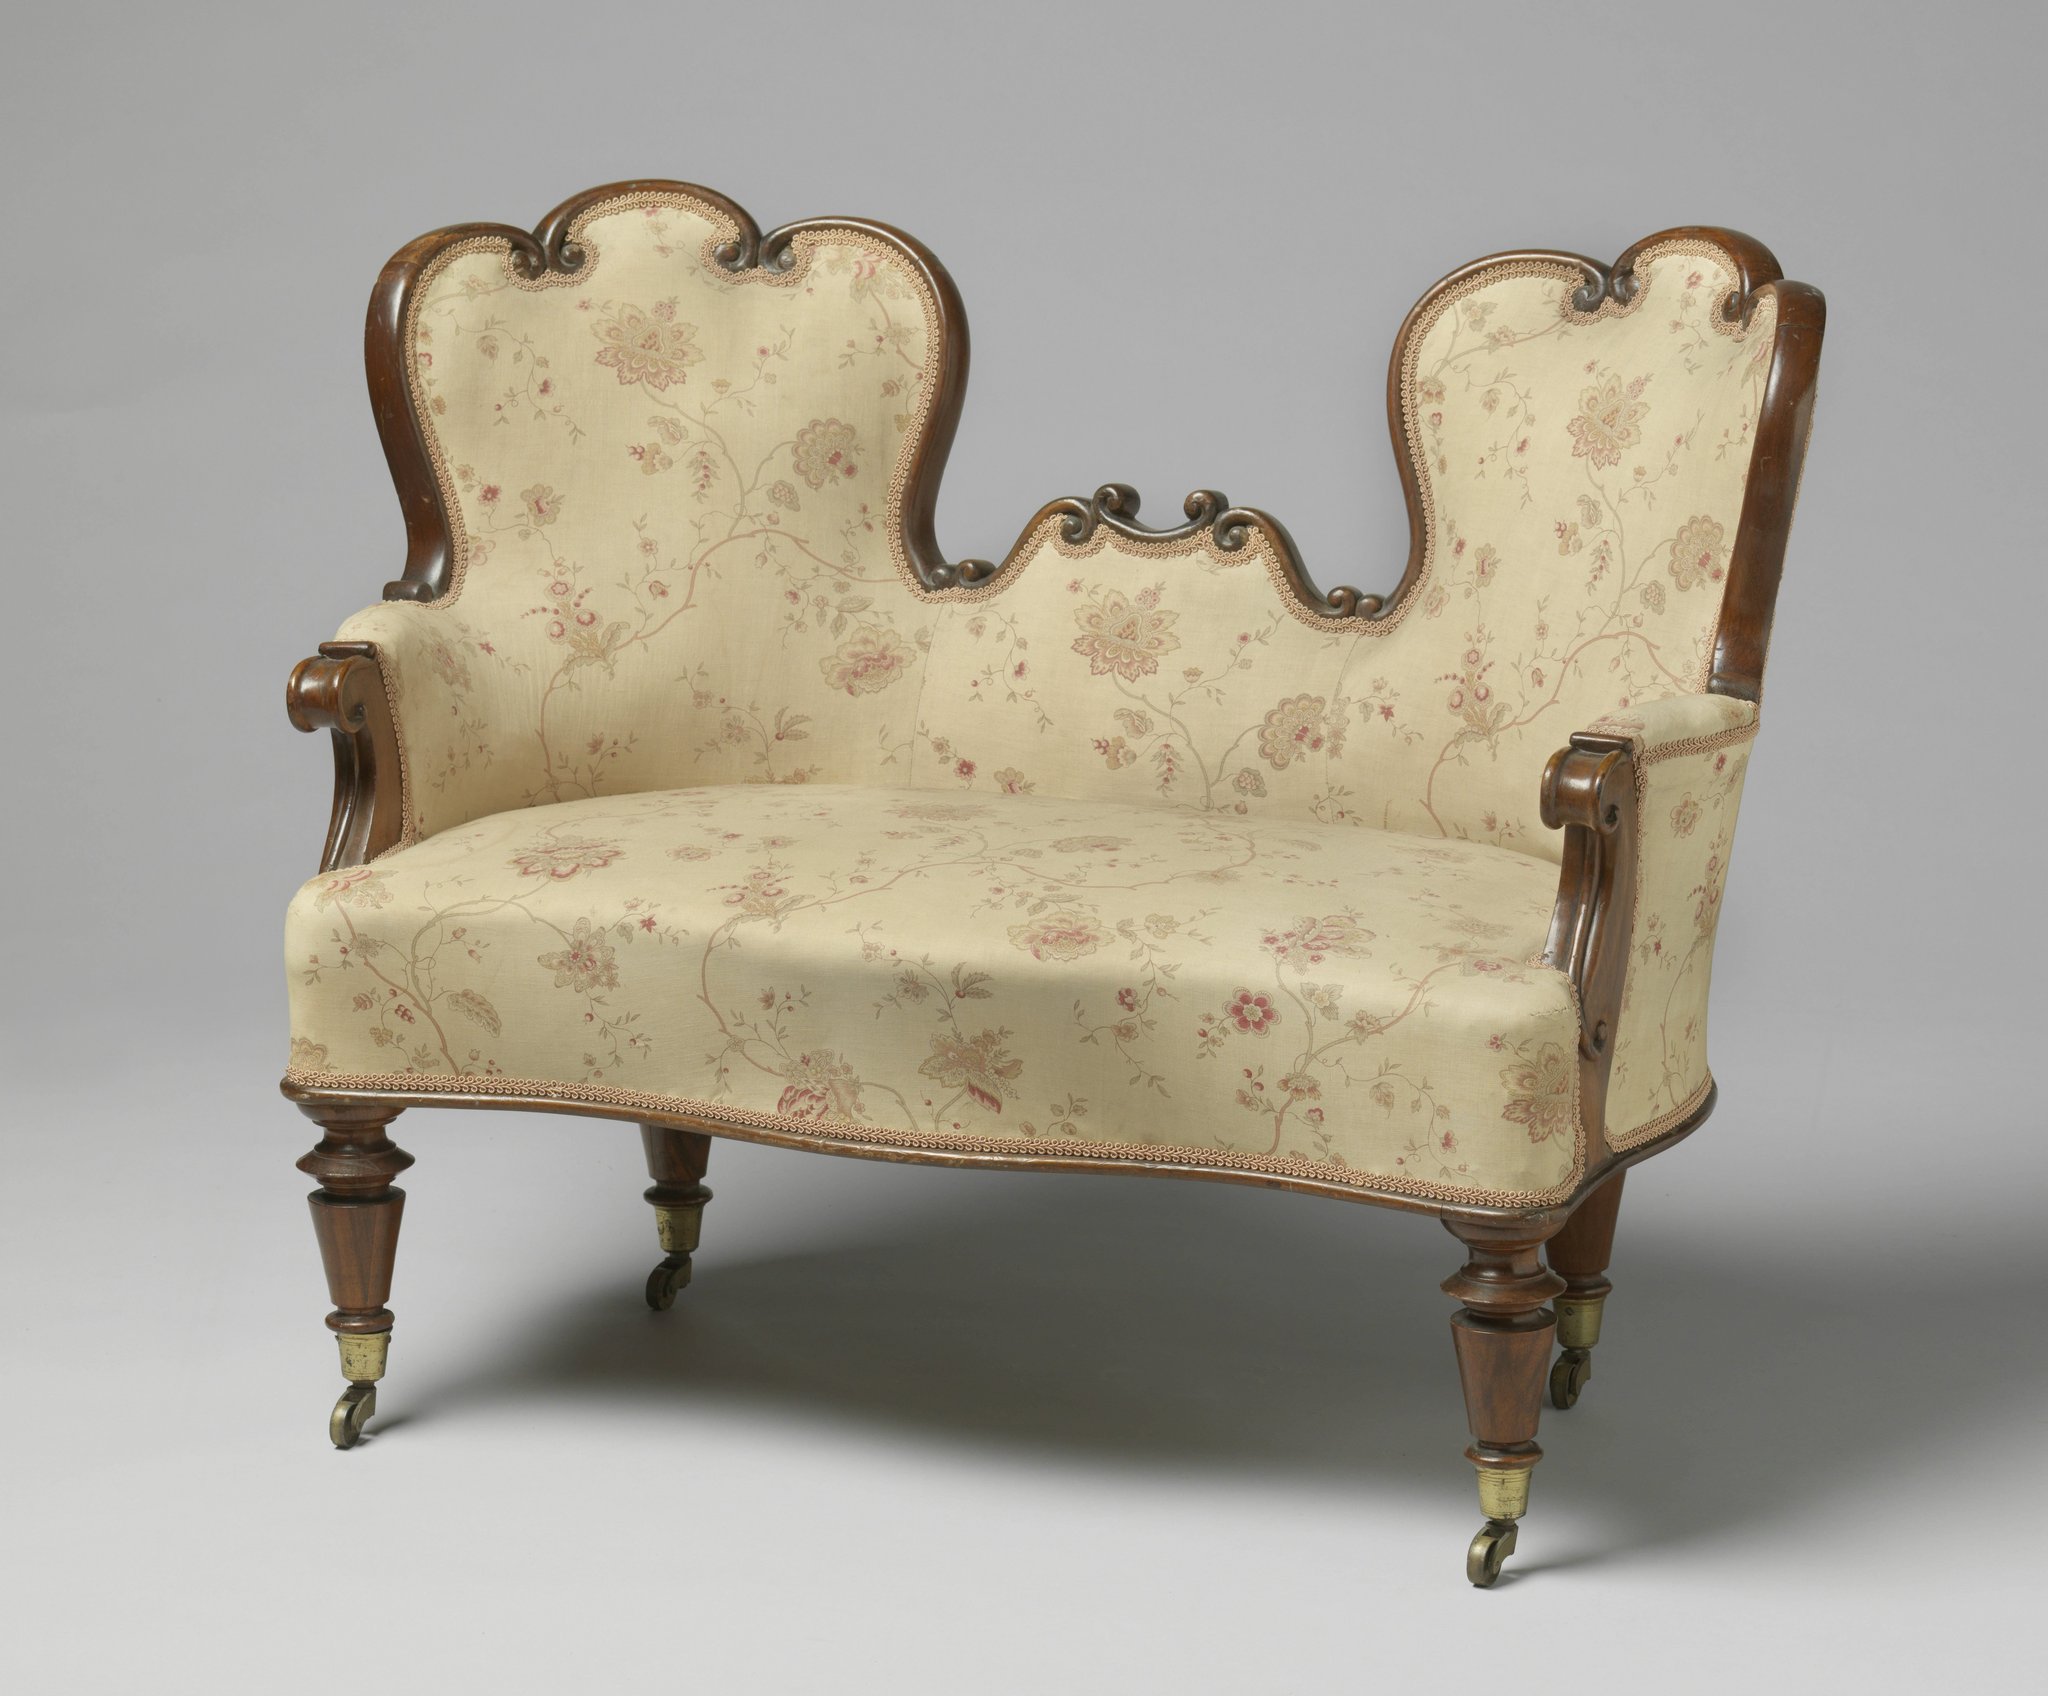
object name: sofa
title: Kinderbank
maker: Anonymous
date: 1850-1875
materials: wood, textile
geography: northern netherlands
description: Bankje van een kinderameublement (bk-1967-182), rustend op vier bolvormige poten, versierd met draaiwerk. Hieronder bevinden zich vier zwenkwieltjes. De zijregels zijn enkel gebogen en de voor- en achterregel zijn dubbel gebogen. De terugwijkende armleggerstutten zijn versierd met voluten; de armleggers zijn grotendeels gestoffeerd. De gestoffeerde rugleuning bestaat uit twee overhoeks geplaatste hogere delen, die een lager gelegen middenstuk flankeren. De kanten van al deze onderdelen zijn opgebouwd uit S- en C-voluten.